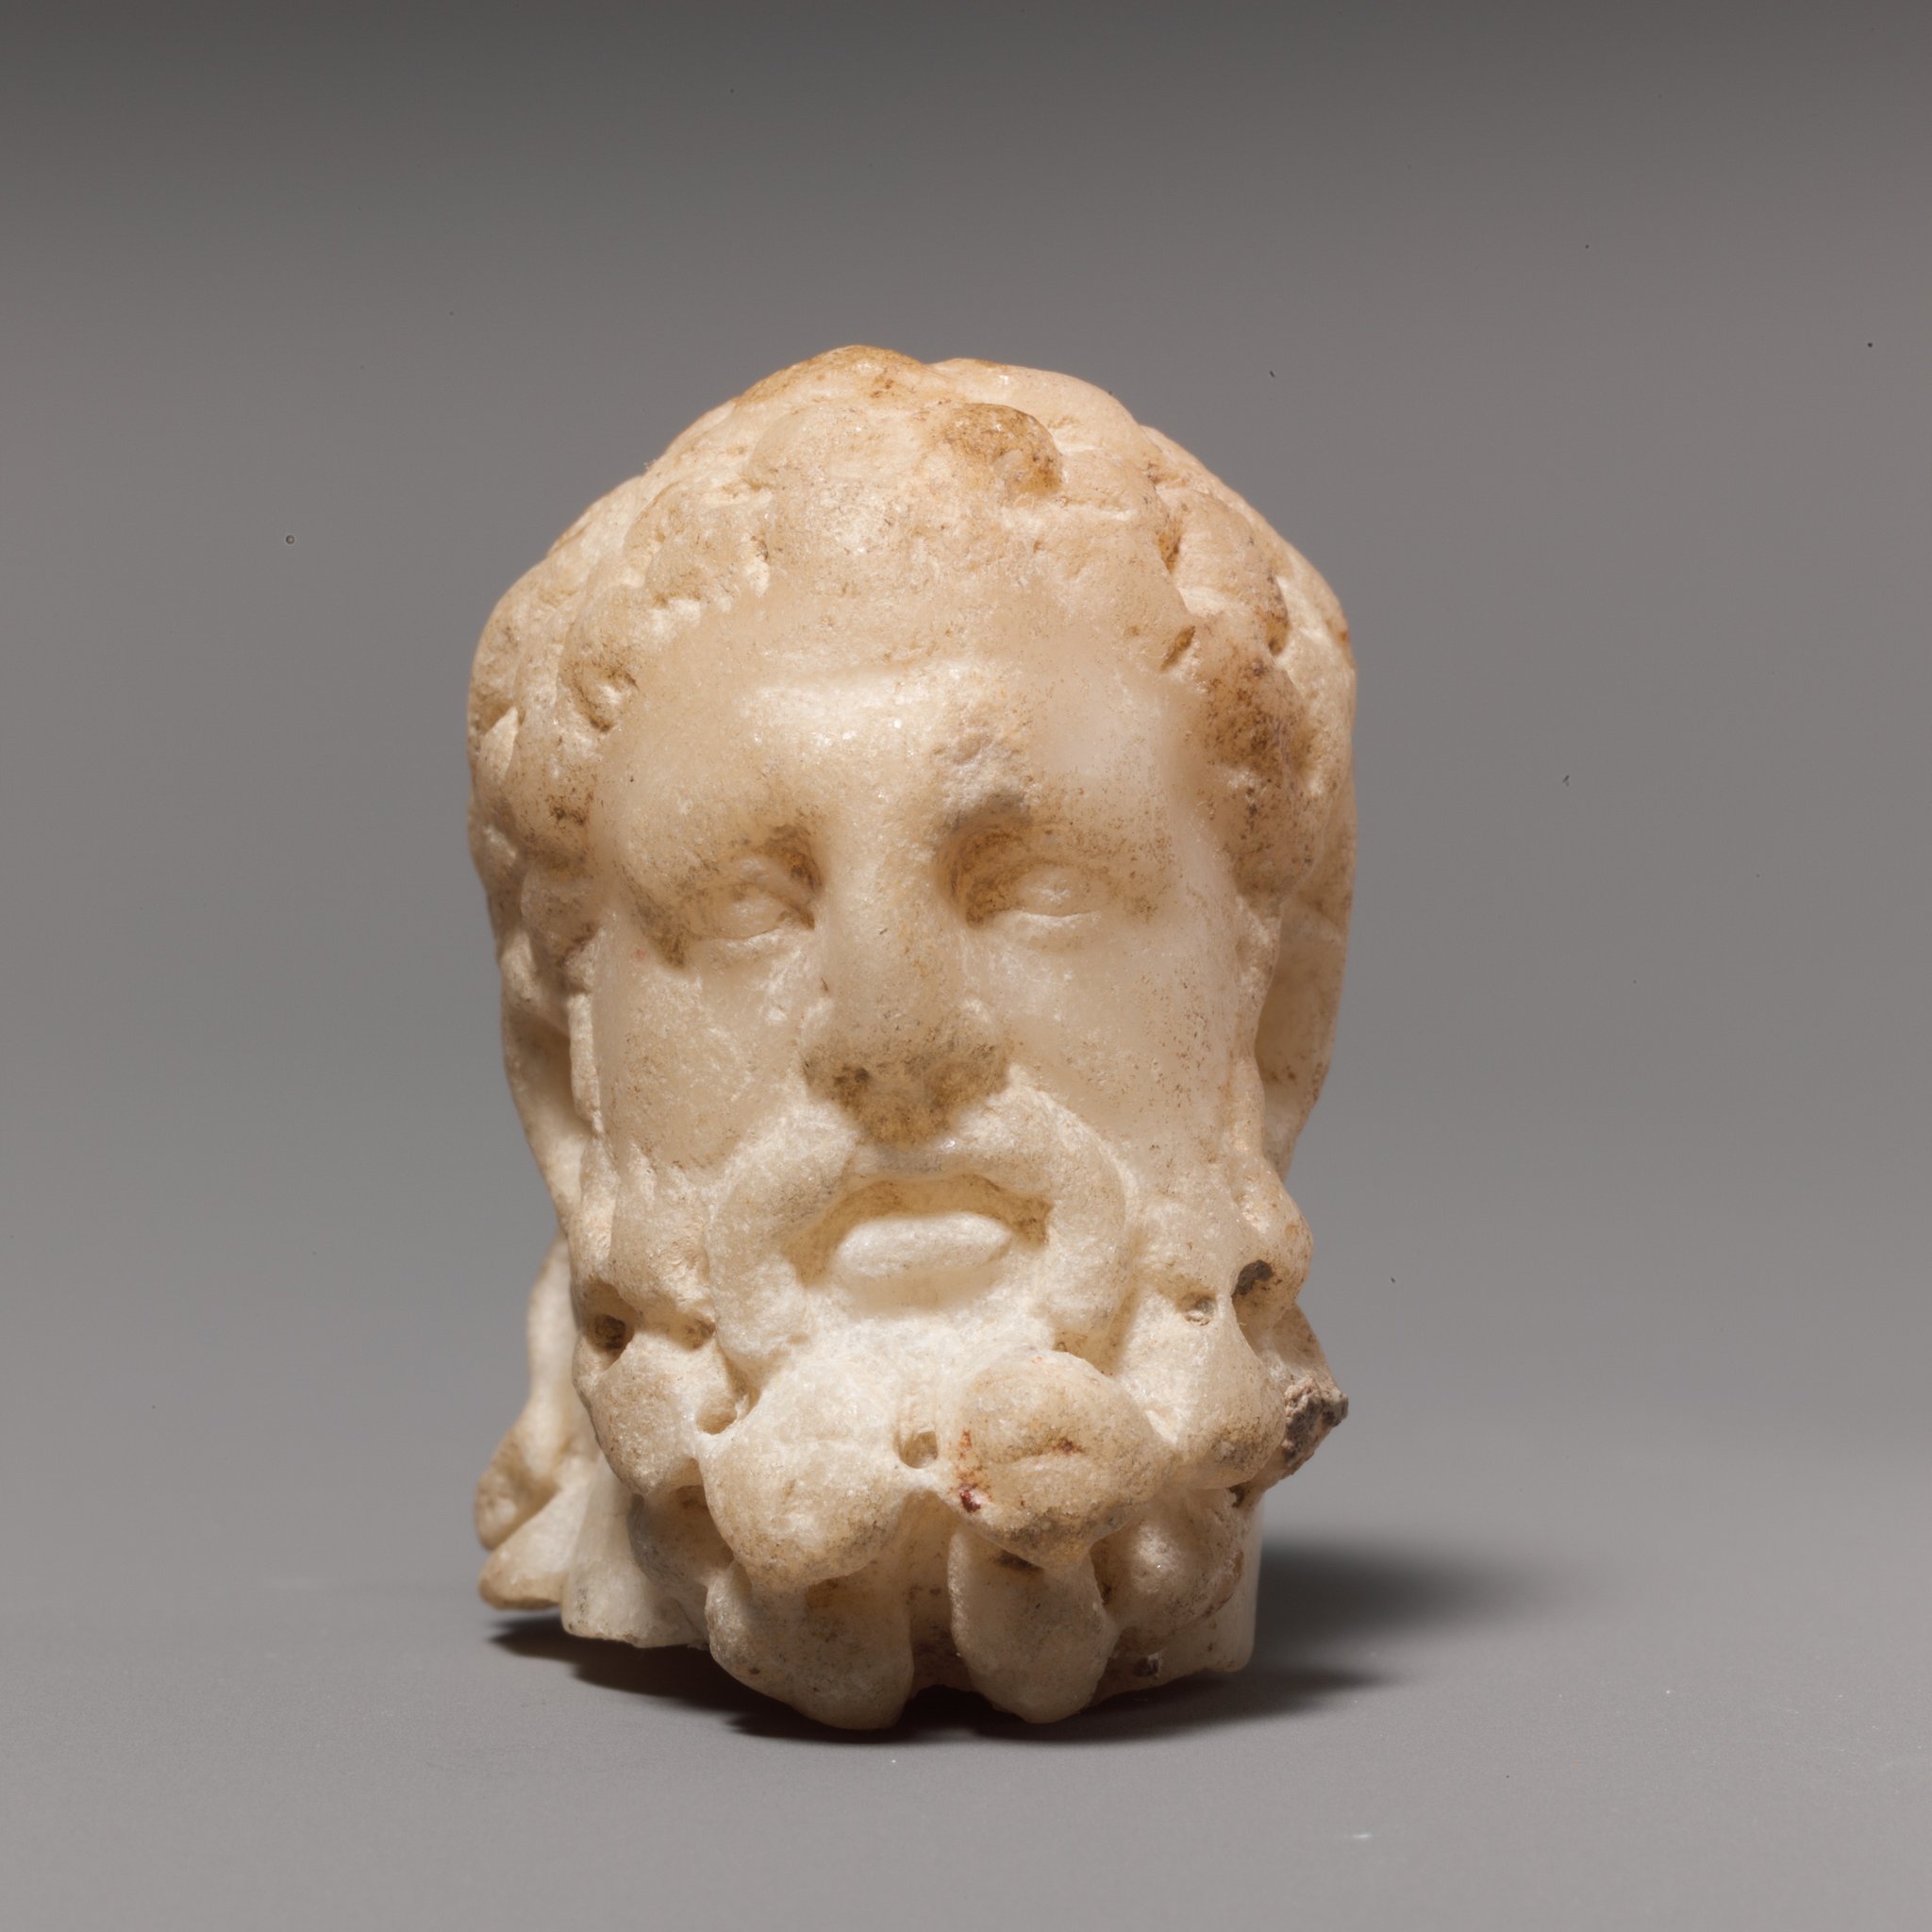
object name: head of herakles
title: Marble head of Hercules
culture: roman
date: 101-200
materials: marble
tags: heads,herakles